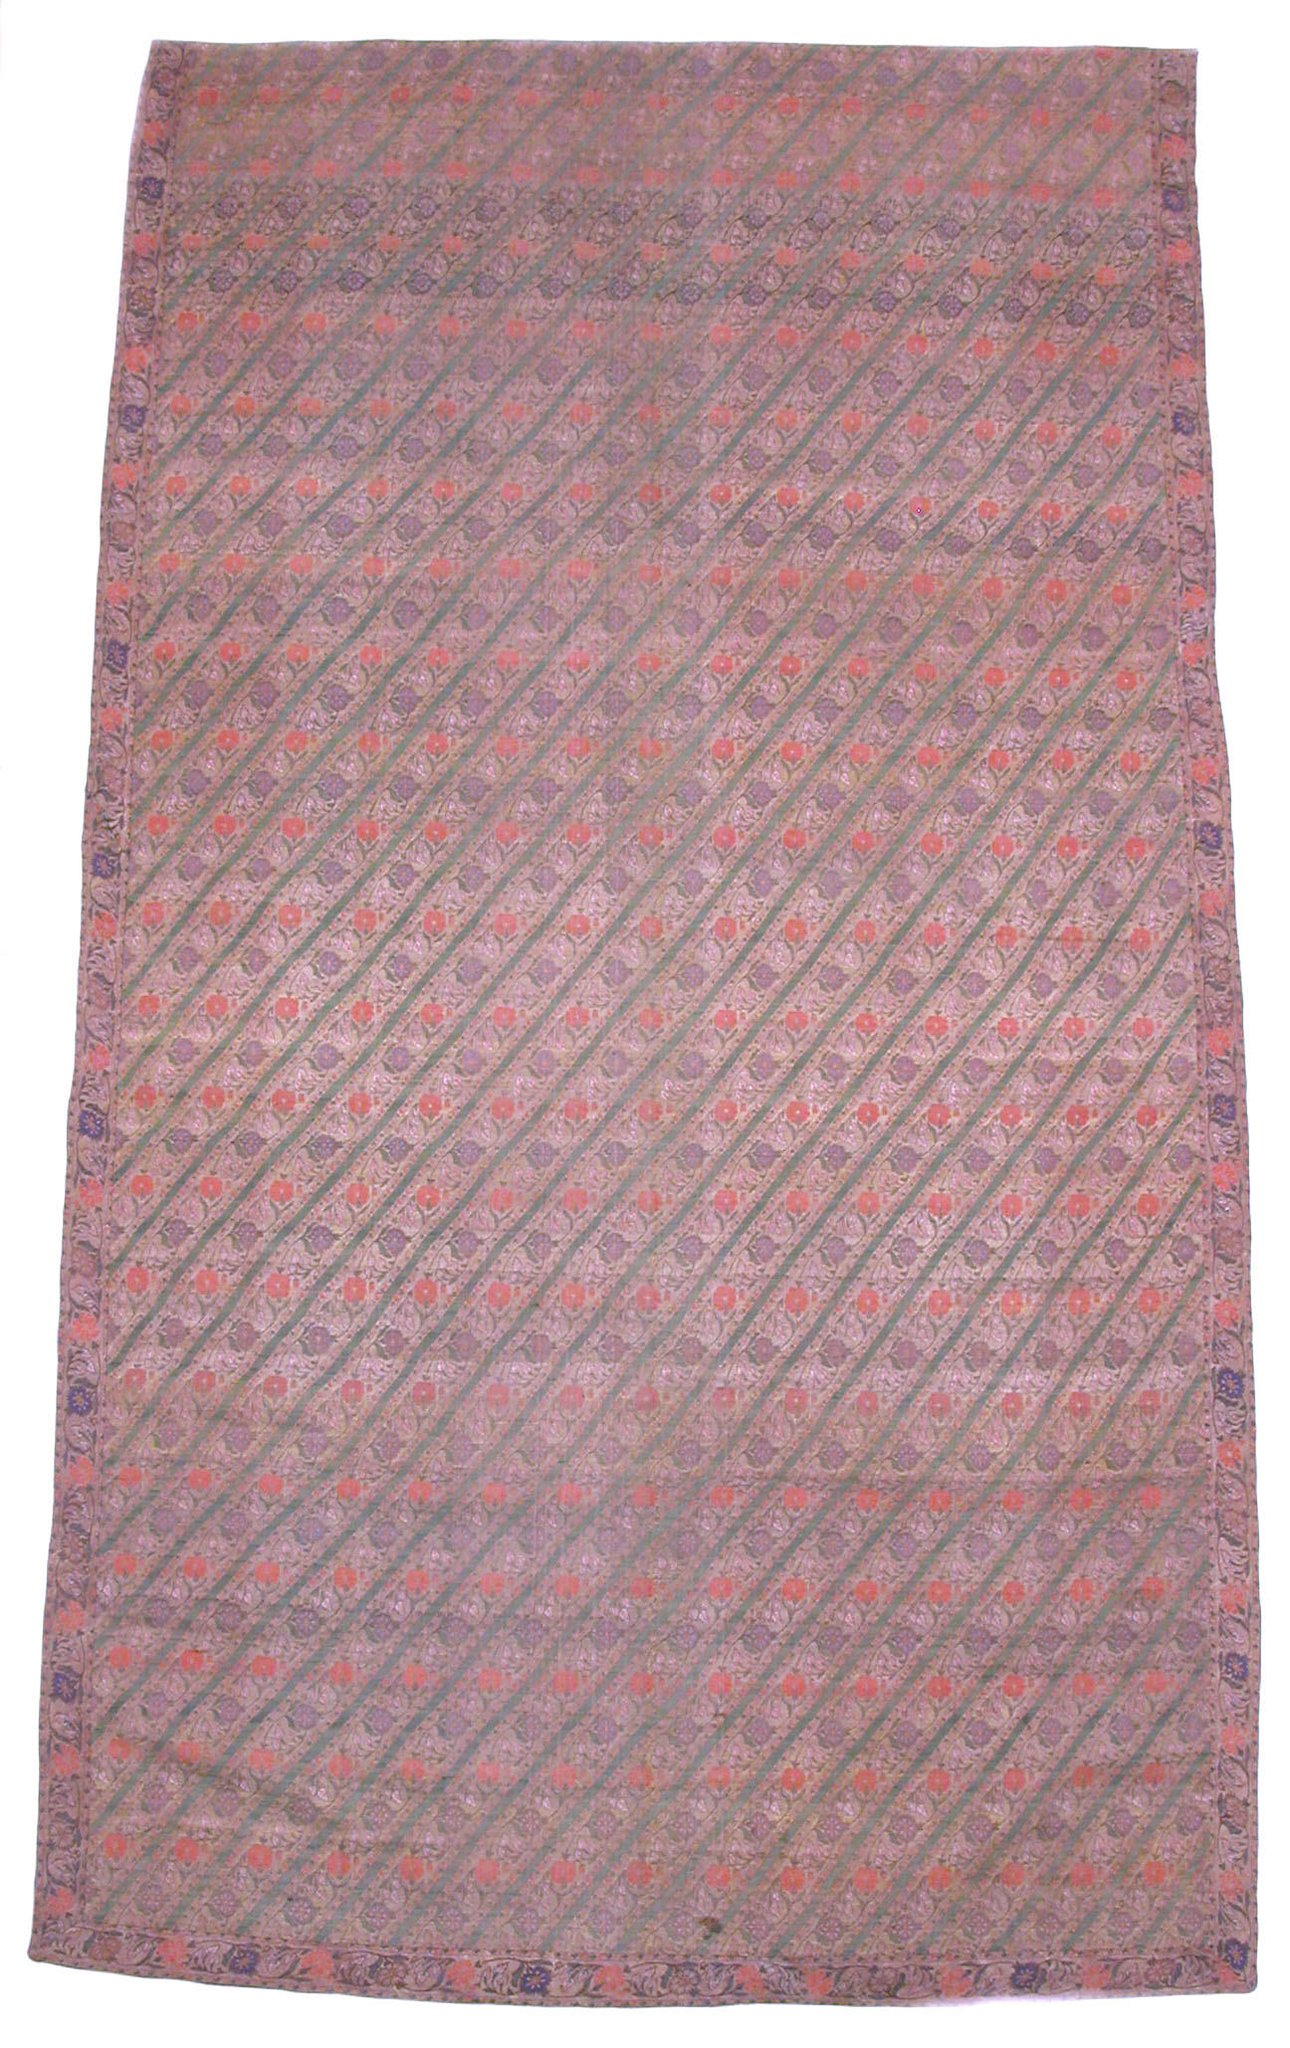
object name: textile fragment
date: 1501-1700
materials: gold, silk, silver, thread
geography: iran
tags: flowers